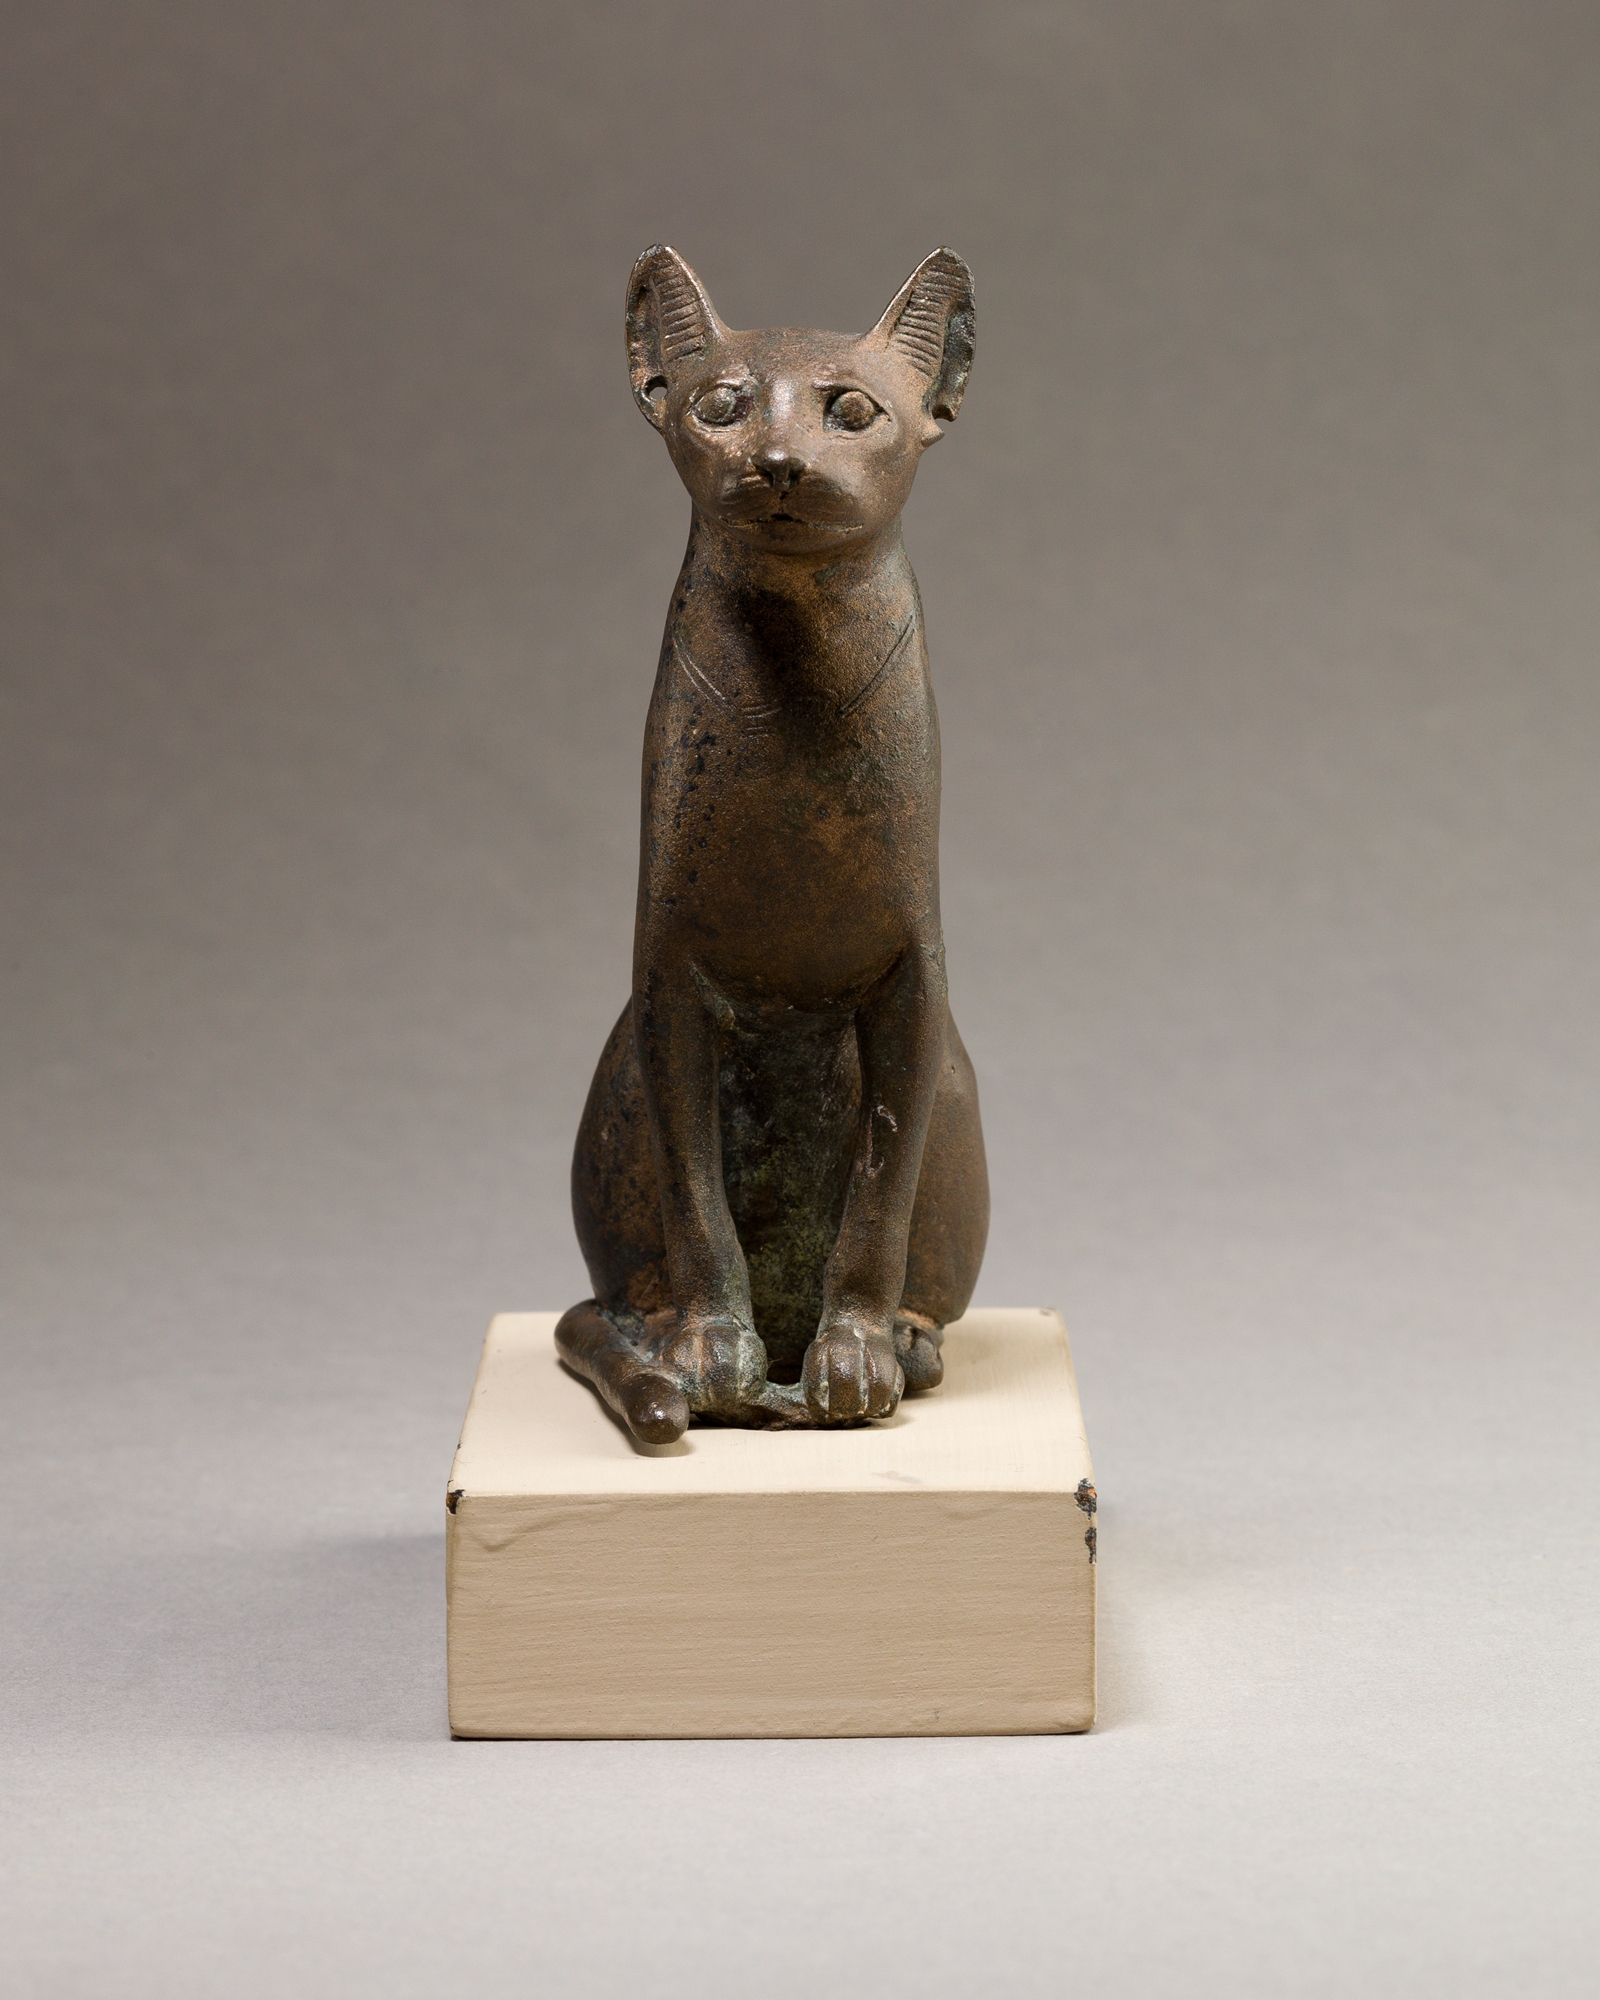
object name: figurine, cat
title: Cat figurine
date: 664-630 BCE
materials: metal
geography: egypt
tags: cats